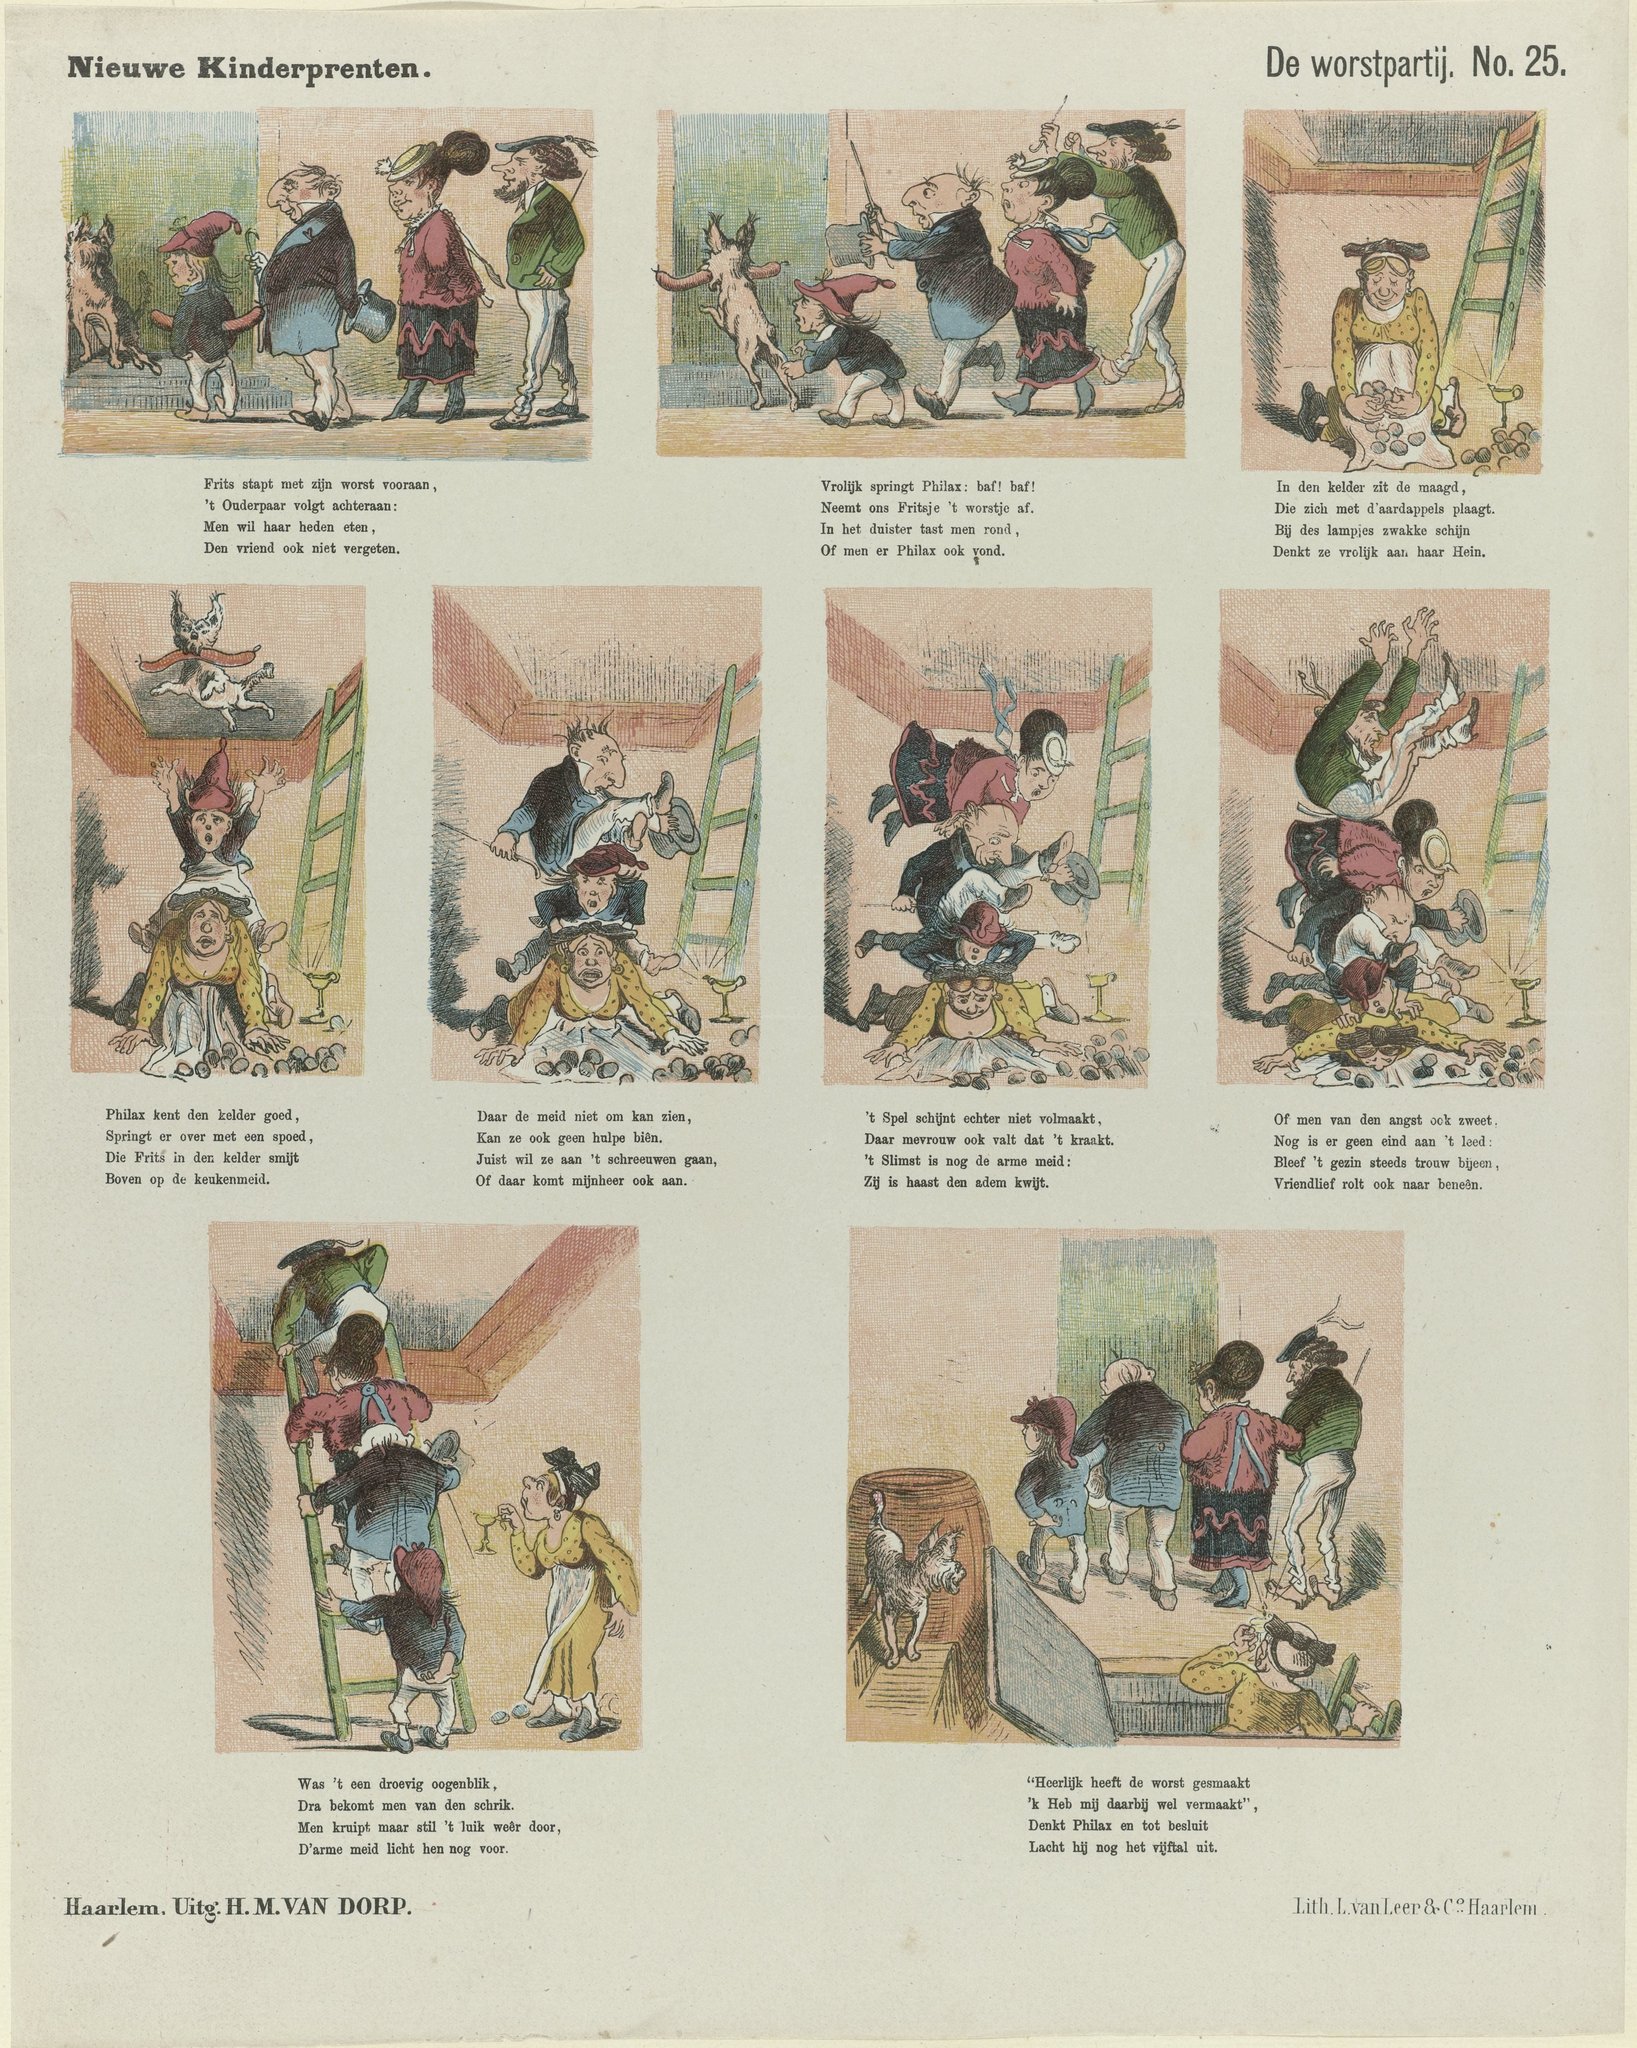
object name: popular print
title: Nieuwe kinderprenten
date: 1872-1883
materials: paper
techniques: lithograph, letterpress printing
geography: haarlem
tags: tales and fairy tales, sausage, dog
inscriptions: collector's mark: Lugt 2760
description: Blad met 9 voorstellingen over een hond die een worst bemachtigt. Onder elke afbeelding een vierregelig vers. Genummerd rechtsboven: No. 25.